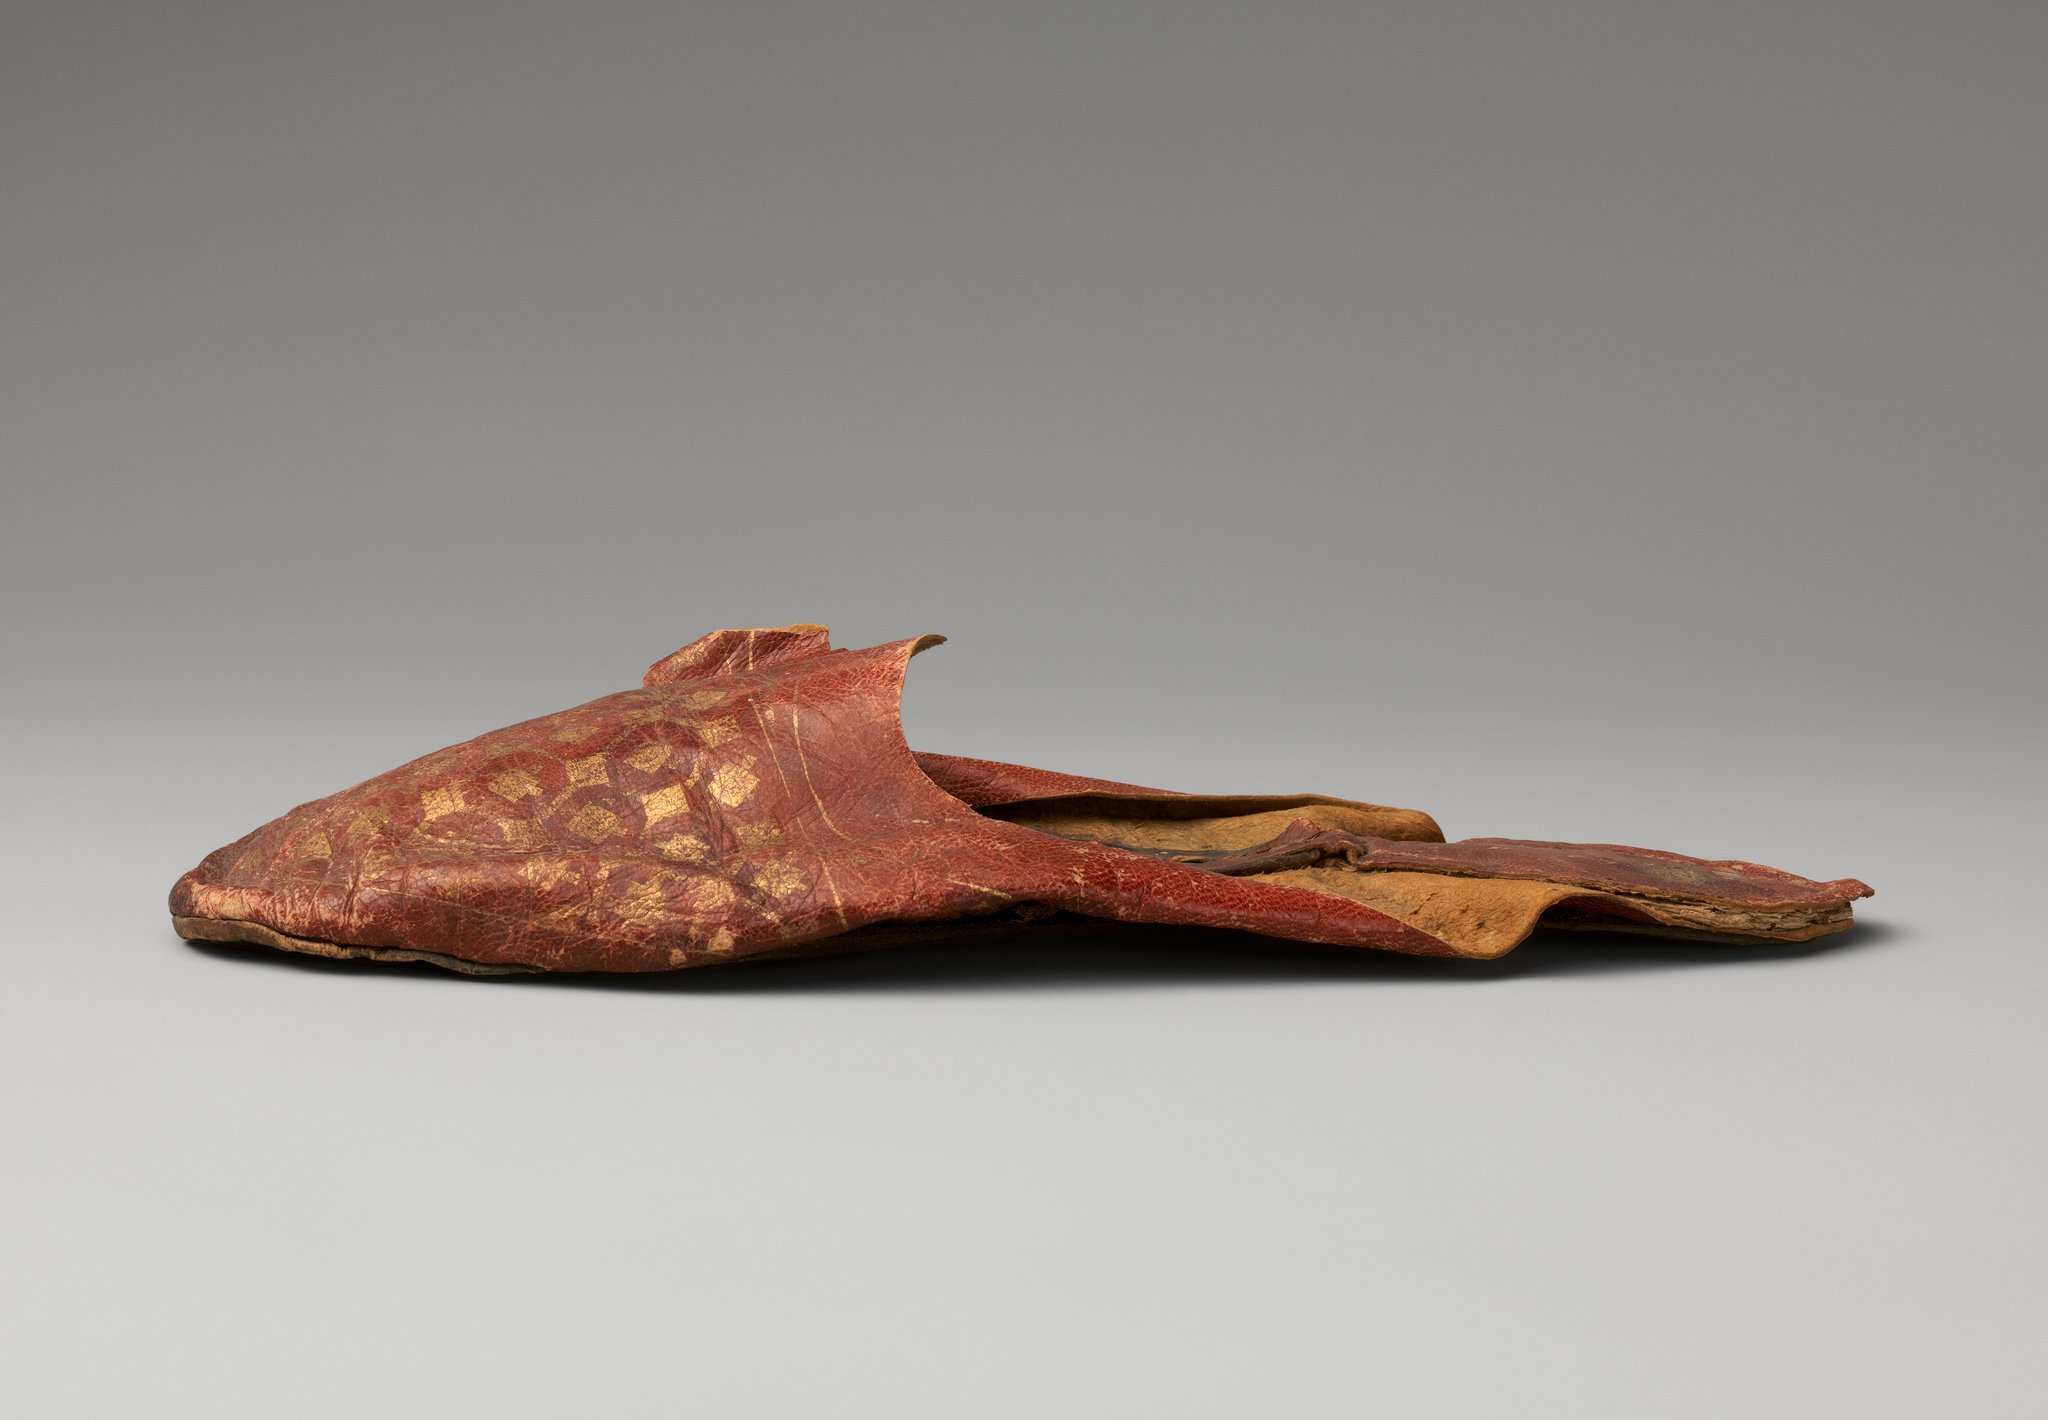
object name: shoe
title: Leather Shoe with Gilded Decoration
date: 301-700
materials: leather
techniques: gilding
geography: egypt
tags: shoes